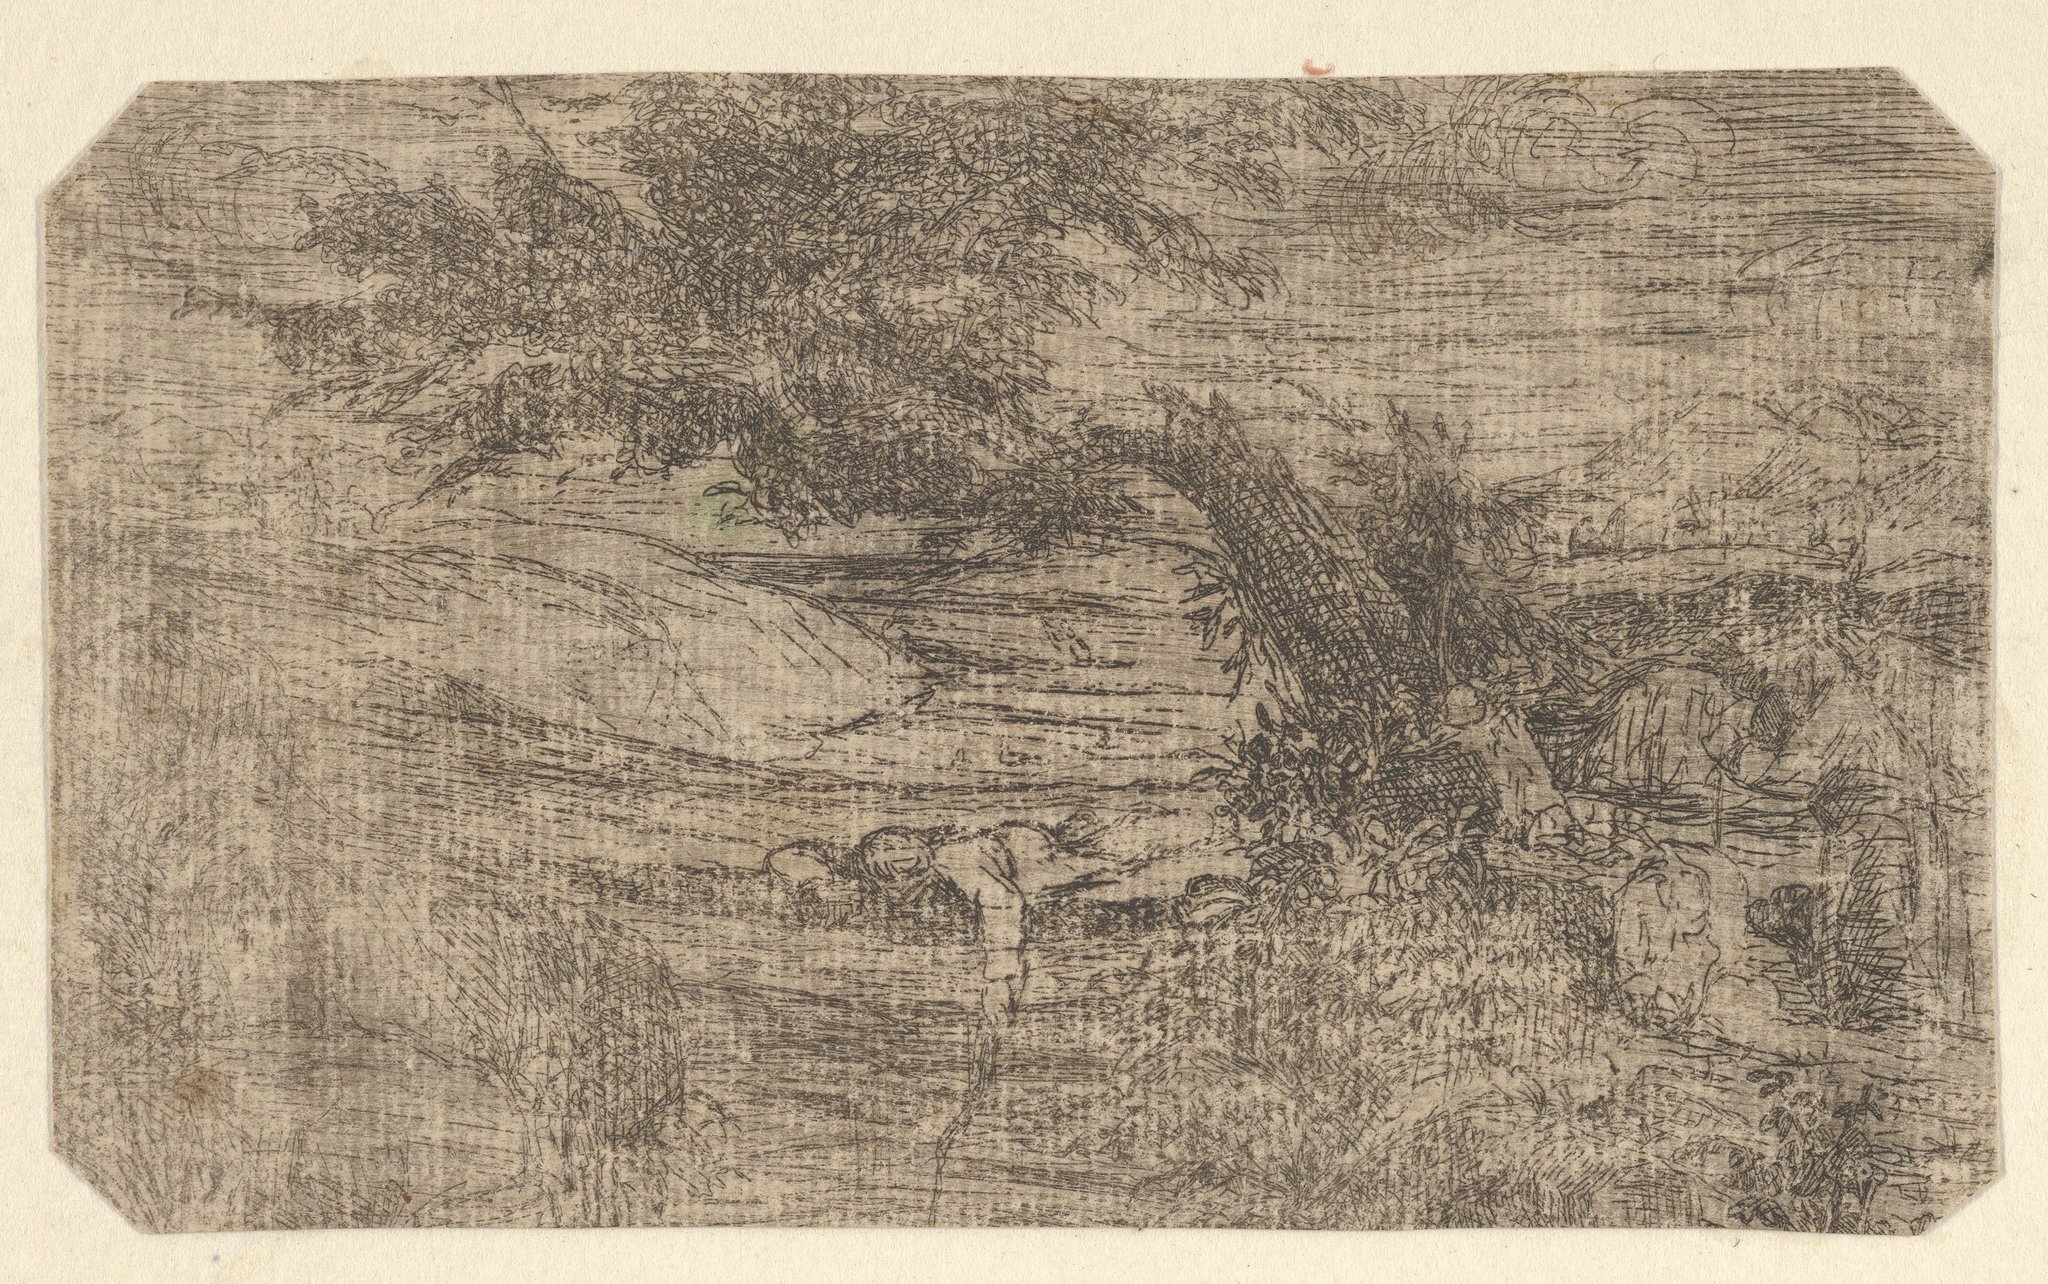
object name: print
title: Le Pêcheur sur le Pont (The Fisherman on the Bridge)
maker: rodolphe bresdin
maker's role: artist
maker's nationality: french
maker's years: 1822-1885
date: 1801-1900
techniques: etching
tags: bridges,men,fishing